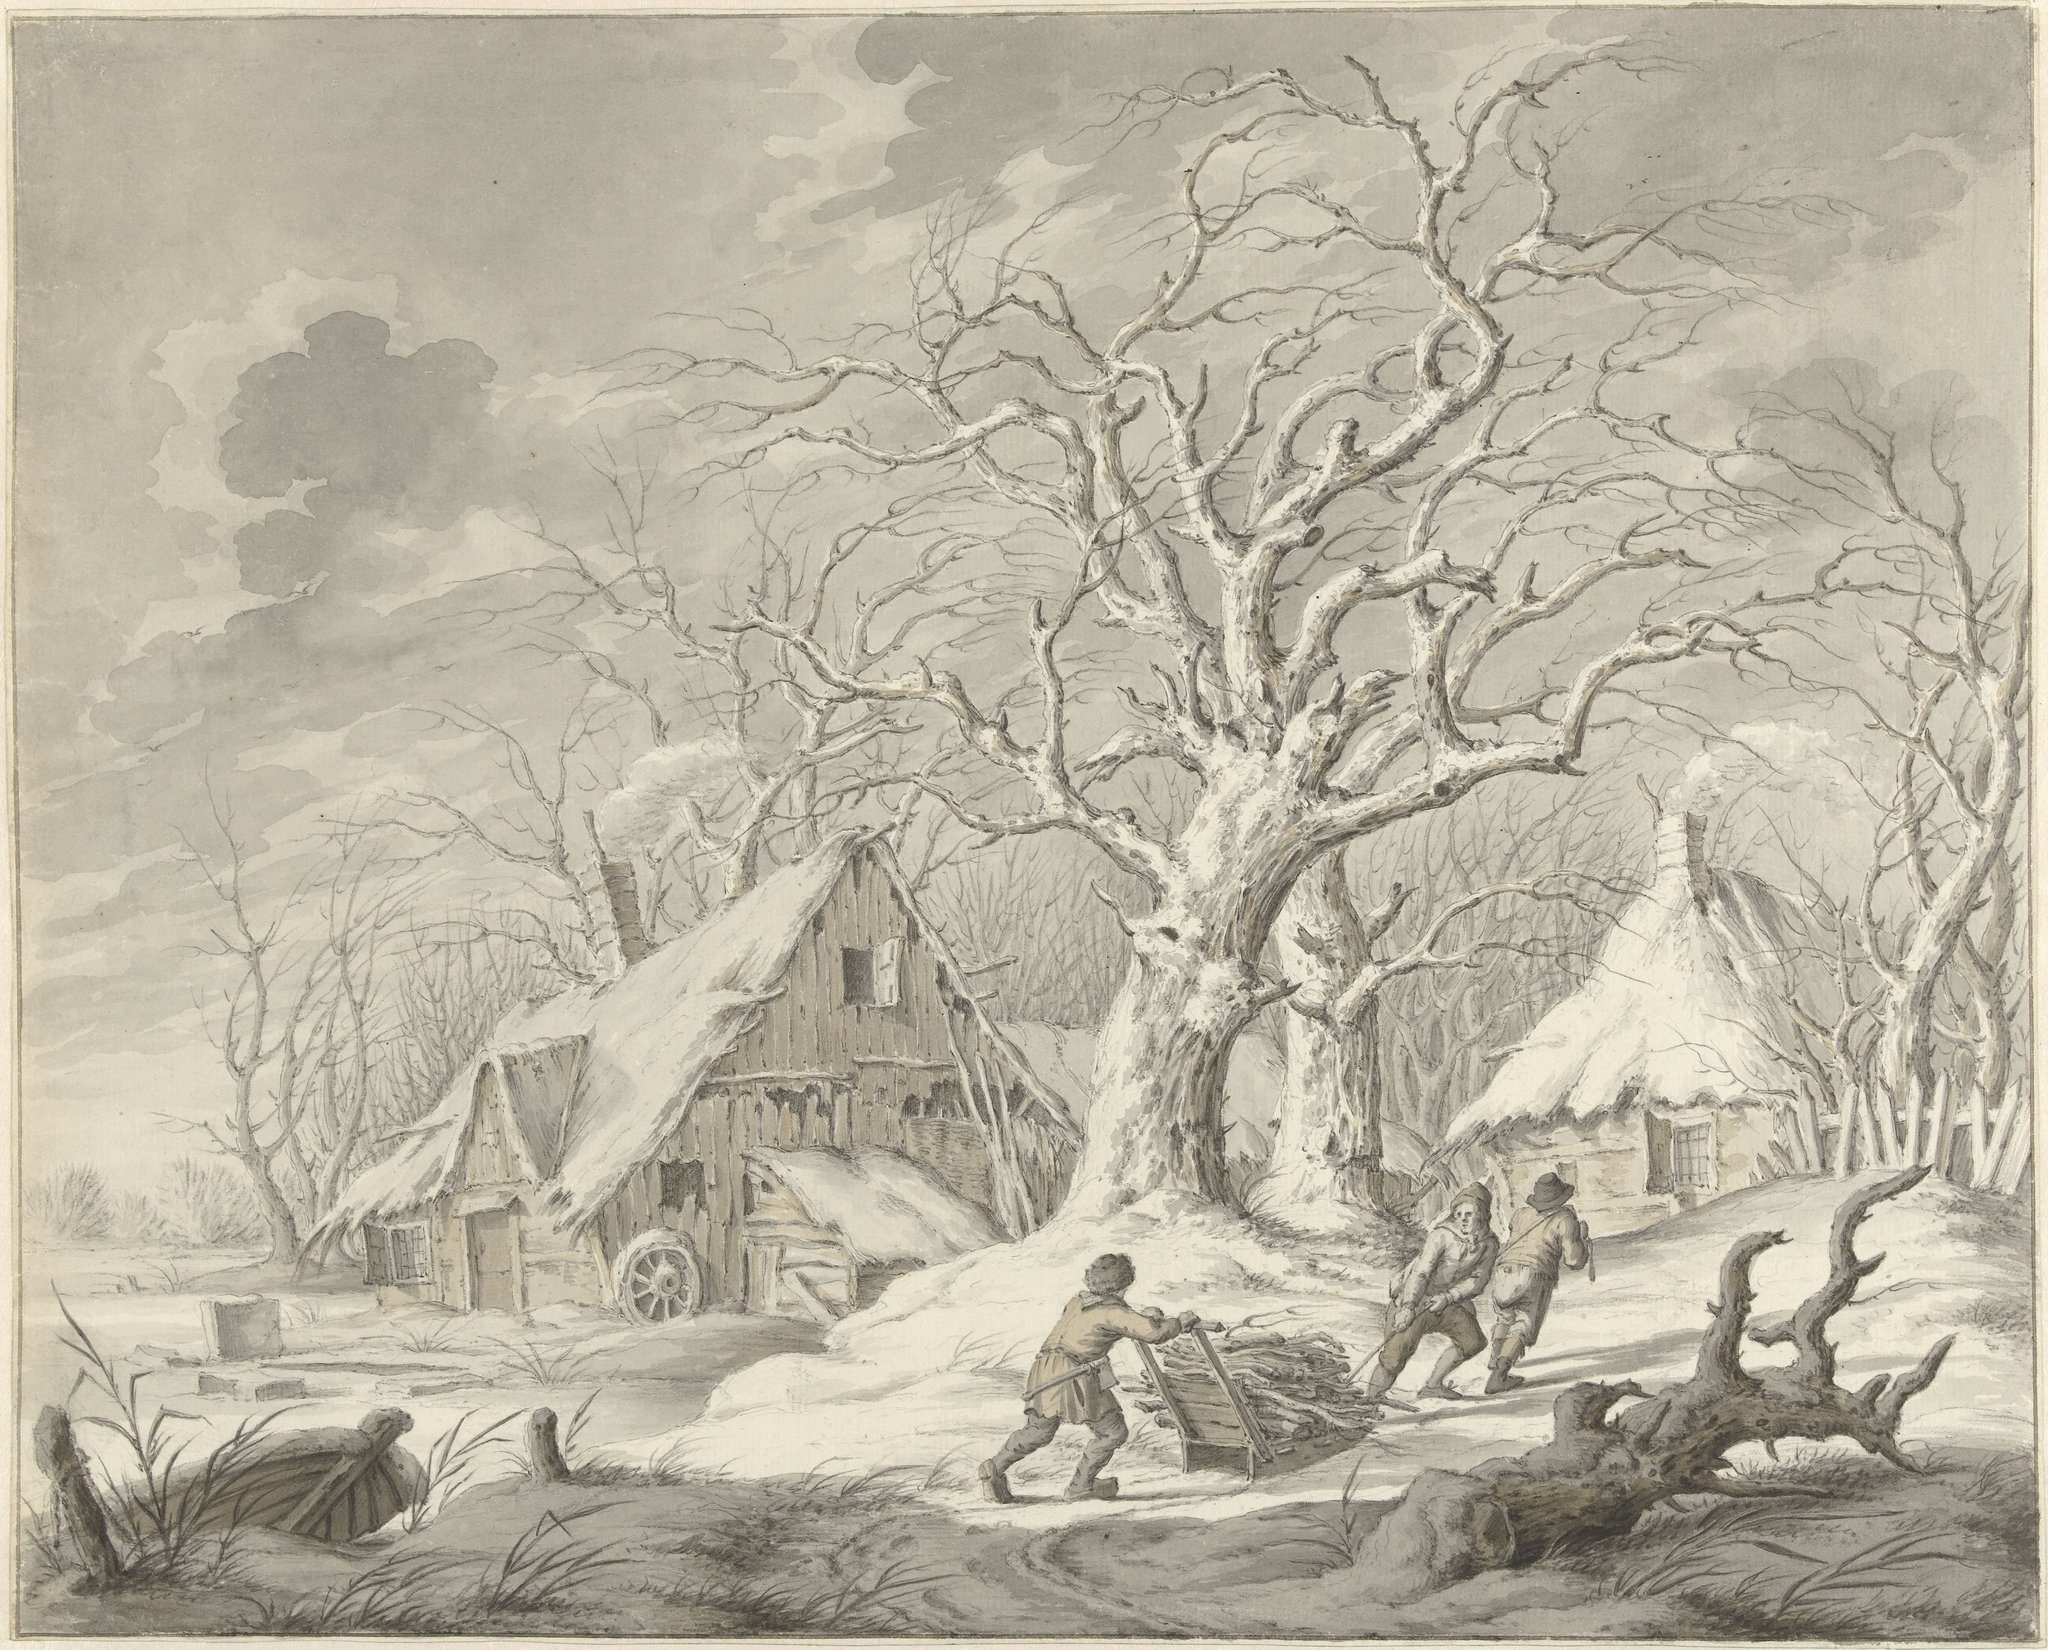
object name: drawing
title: Winterlandschap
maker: johannes jelgerhuis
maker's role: draughtsman, painter, print maker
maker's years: 1770-1836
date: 1780-1836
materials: chalk, paper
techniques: brush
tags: snow